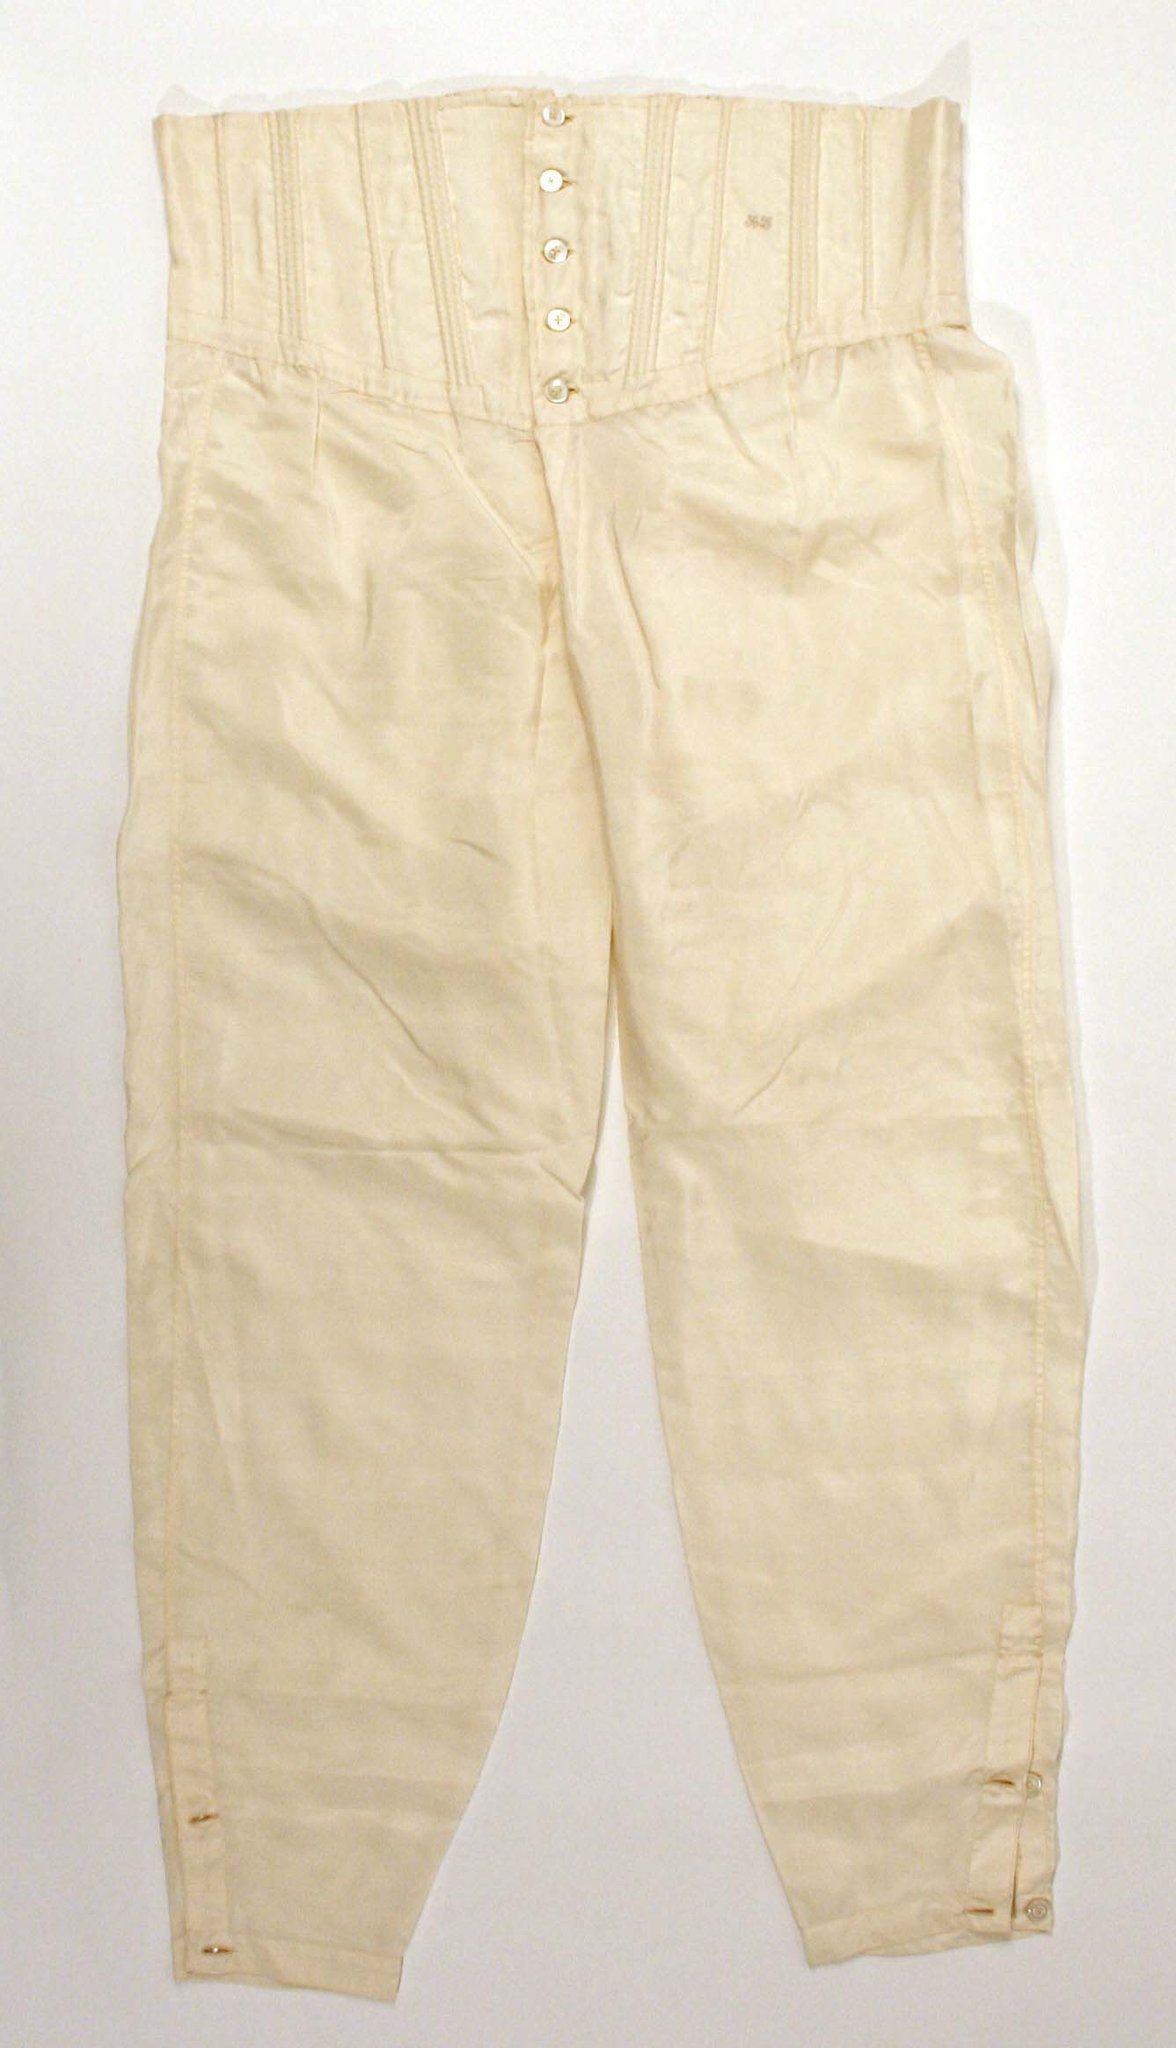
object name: underwear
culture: american or european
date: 1870-1900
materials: silk